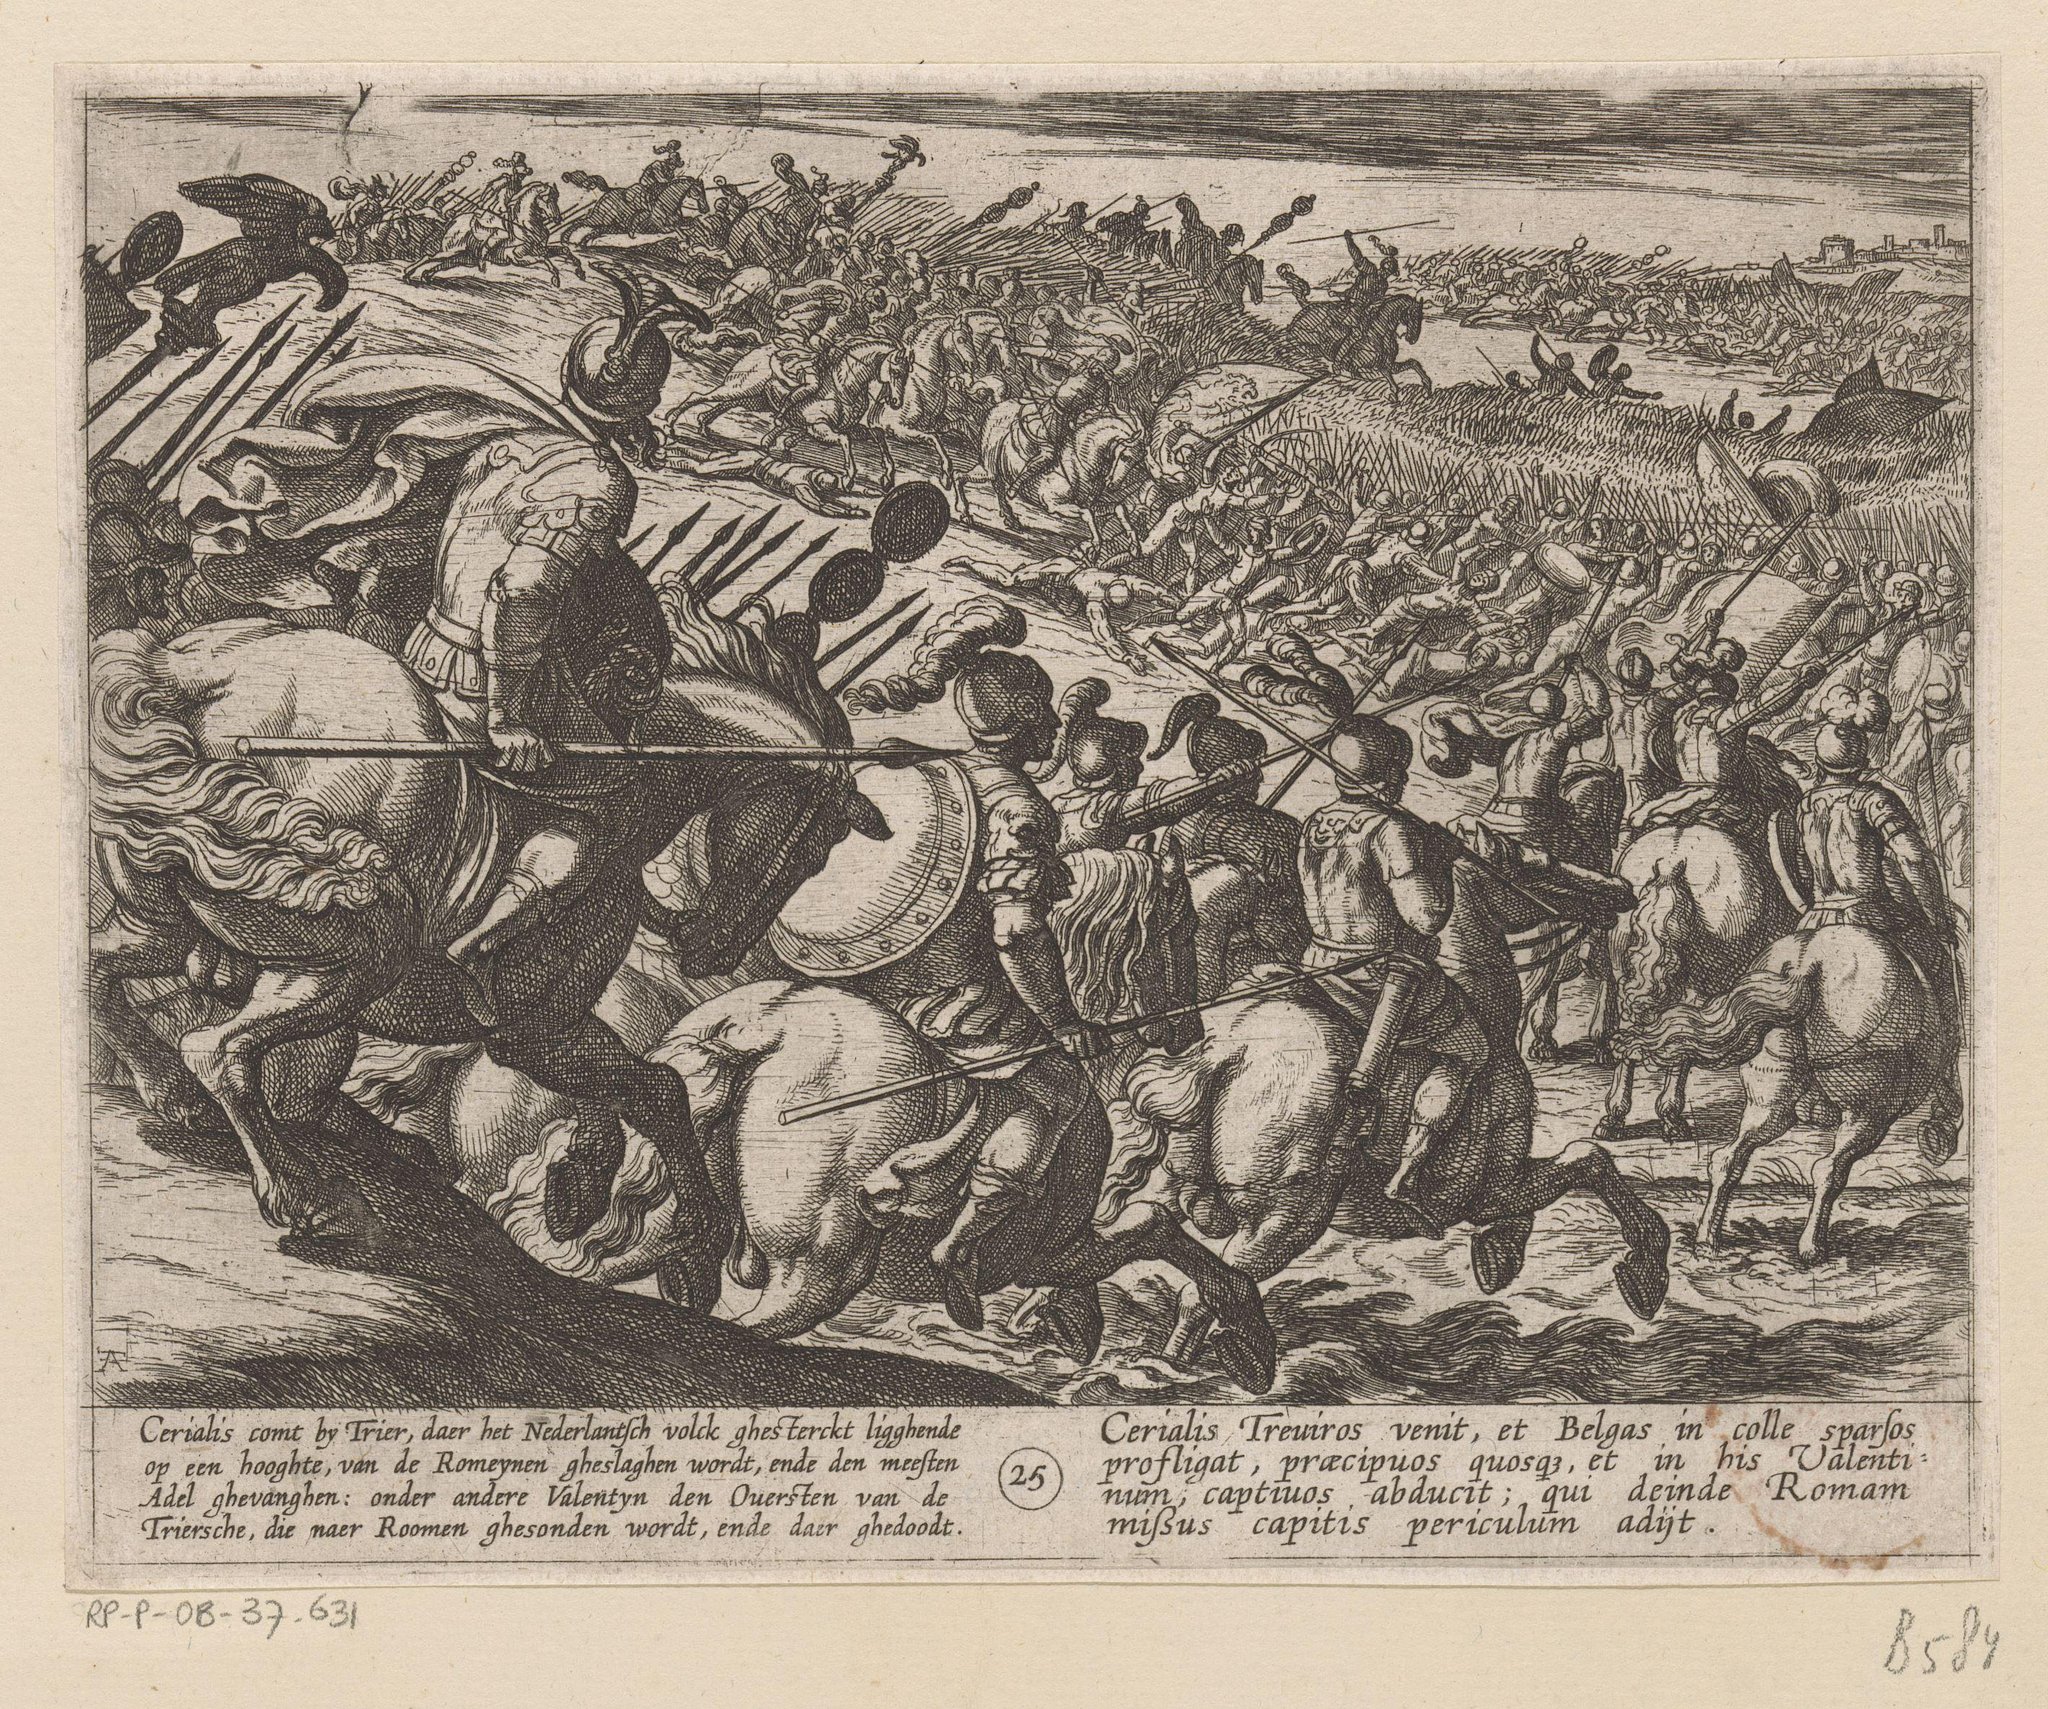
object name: print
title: Batavorum cum Romanis Bellum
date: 1611-1612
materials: paper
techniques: etching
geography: italy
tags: battle, warfare; military affairs (+ cavalry, horsemen), the soldier; the soldier's life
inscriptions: collector's mark: Lugt 240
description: De Romeinse aanvoerder Cerialis en zijn leger vallen de Treviri aan bij Trier. Onderschrift in het Nederlands en in het Latijn.